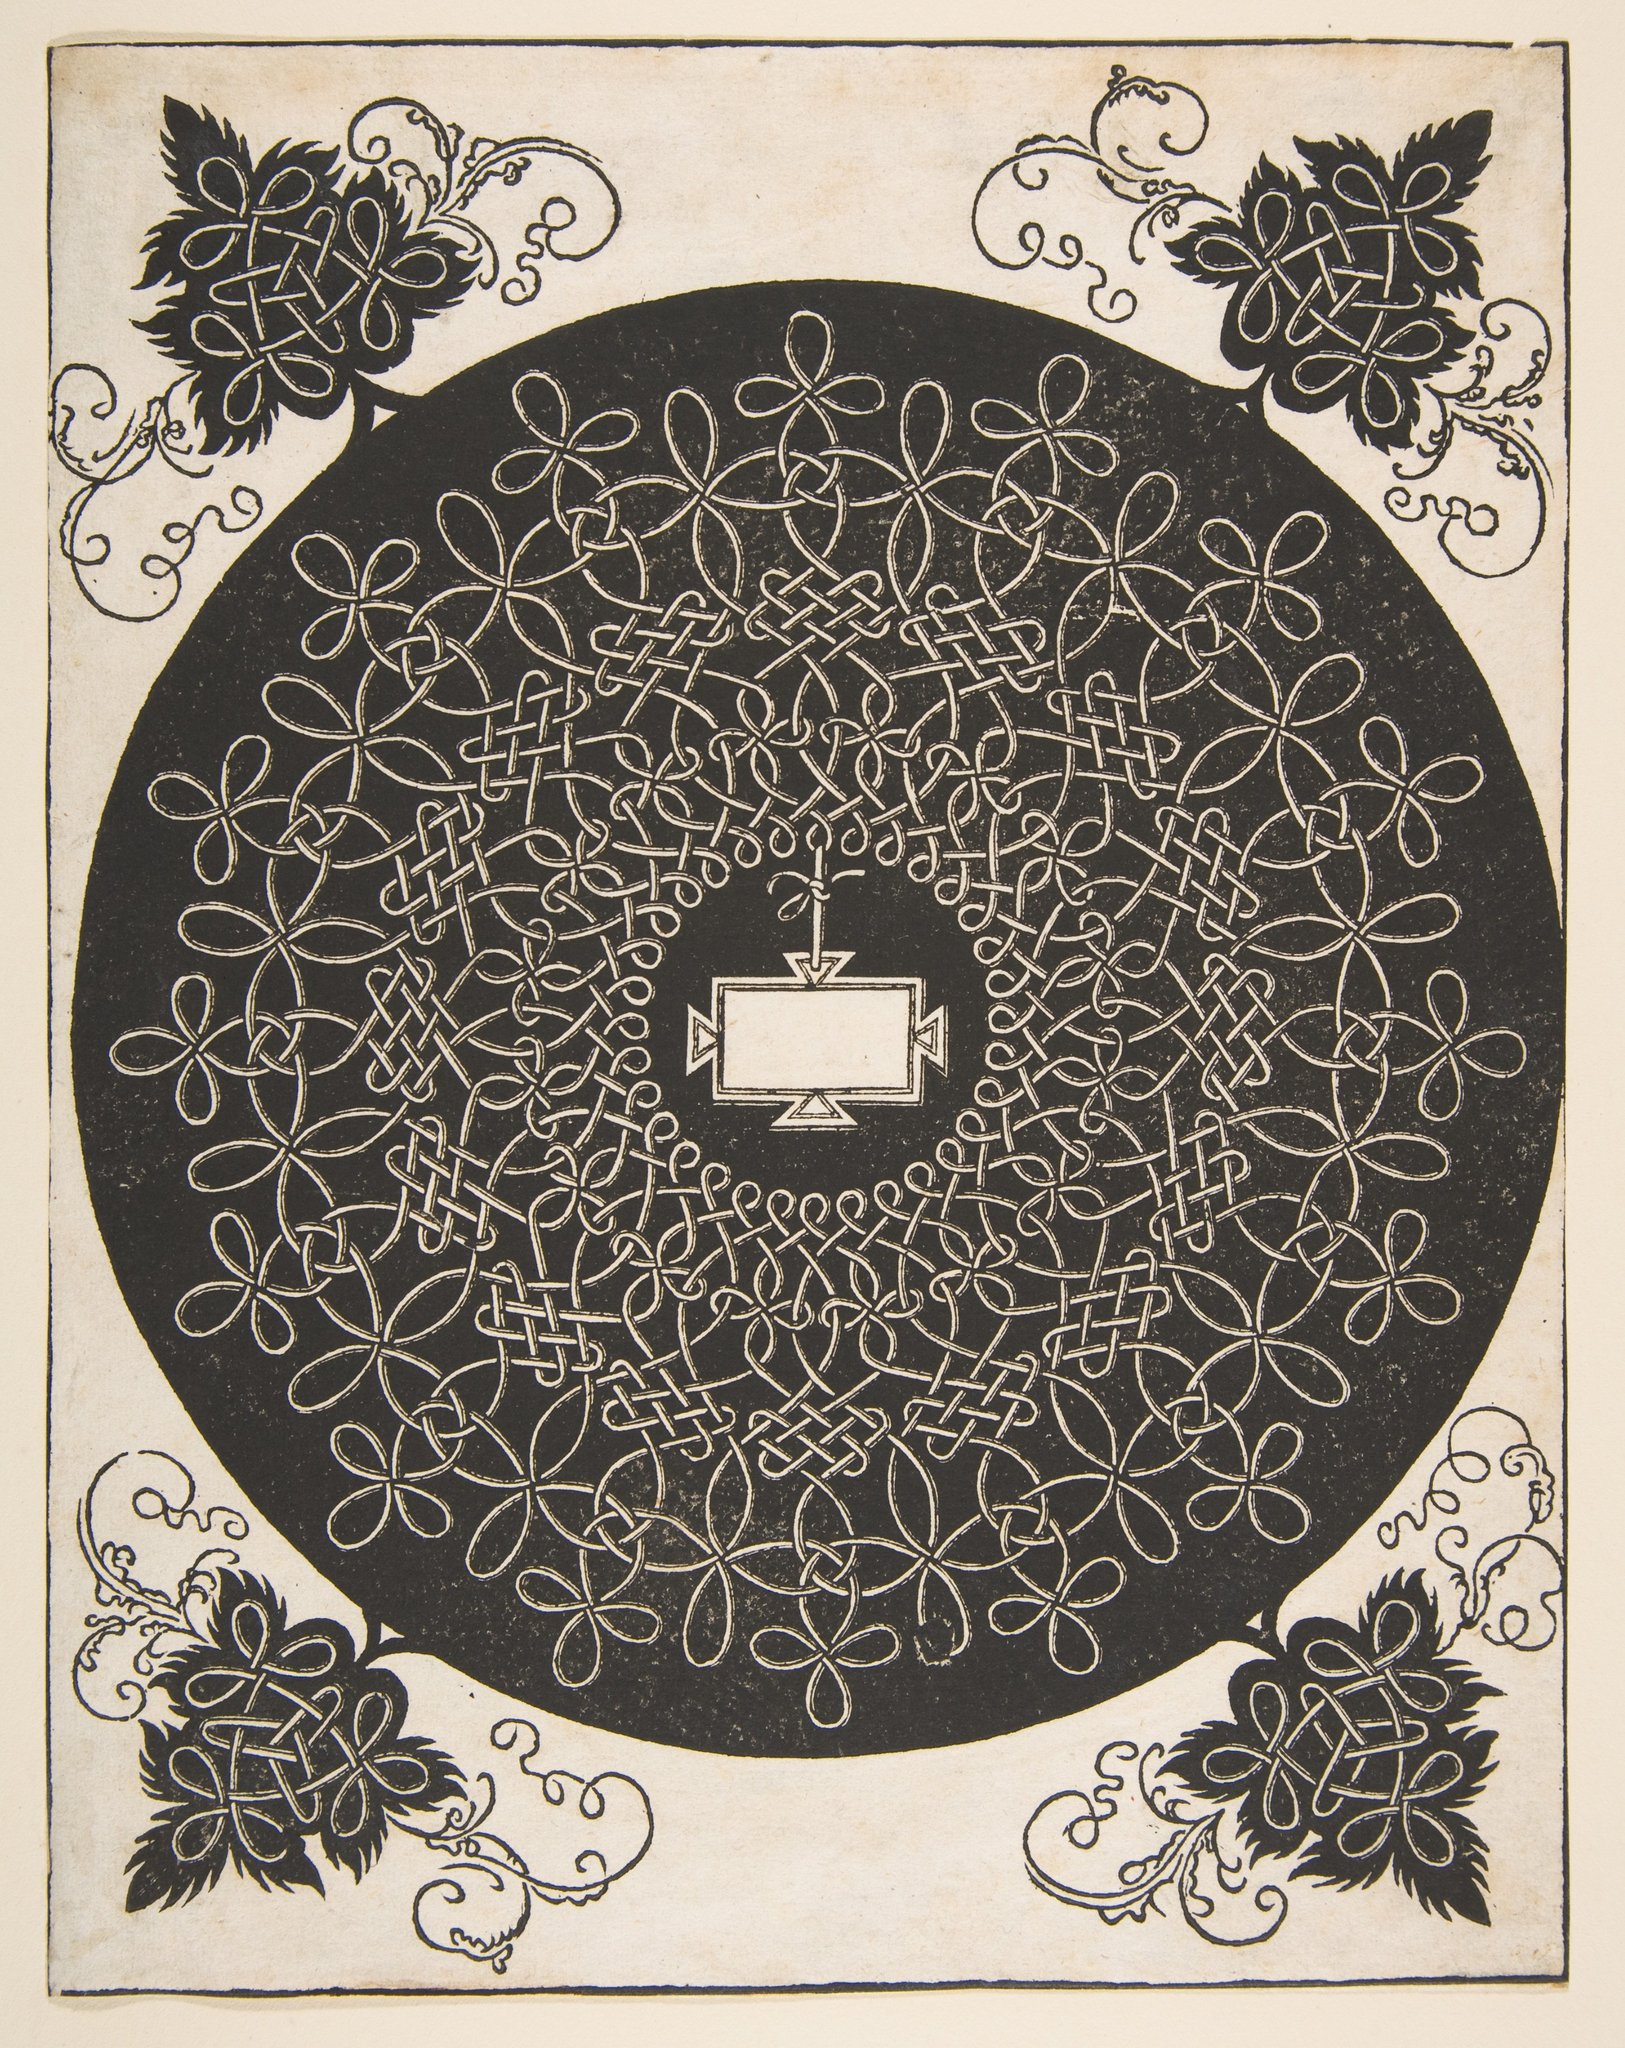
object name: collection ornament architecture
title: Embroidery Pattern with an Oblong Panel in its Center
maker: albrecht dürer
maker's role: artist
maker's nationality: german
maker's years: 1471-1528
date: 1521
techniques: woodcut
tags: ornament